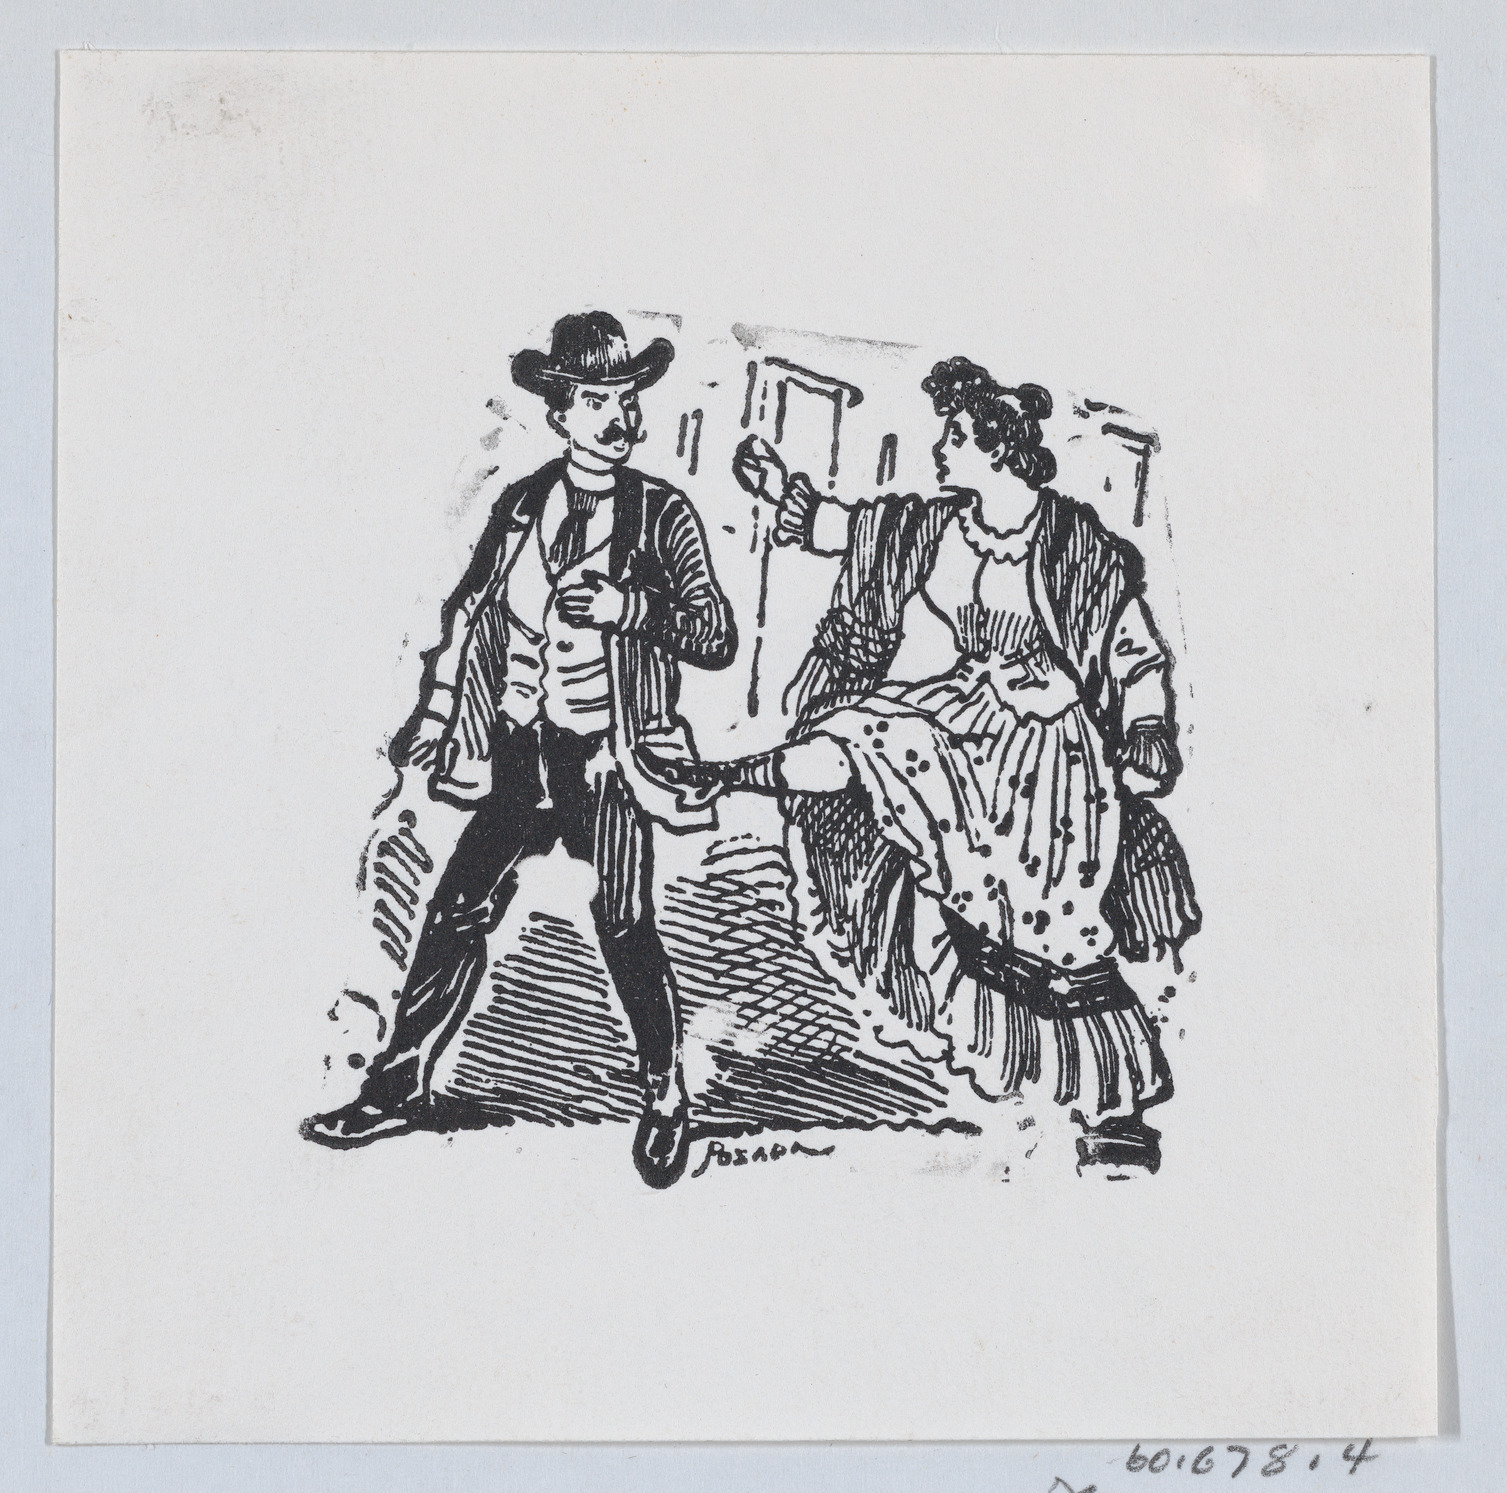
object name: print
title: A woman kicking a man while he walks away from her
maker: josé guadalupe posada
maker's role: artist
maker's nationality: mexican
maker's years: 1852-1913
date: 1880-1910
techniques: lithography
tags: men,women